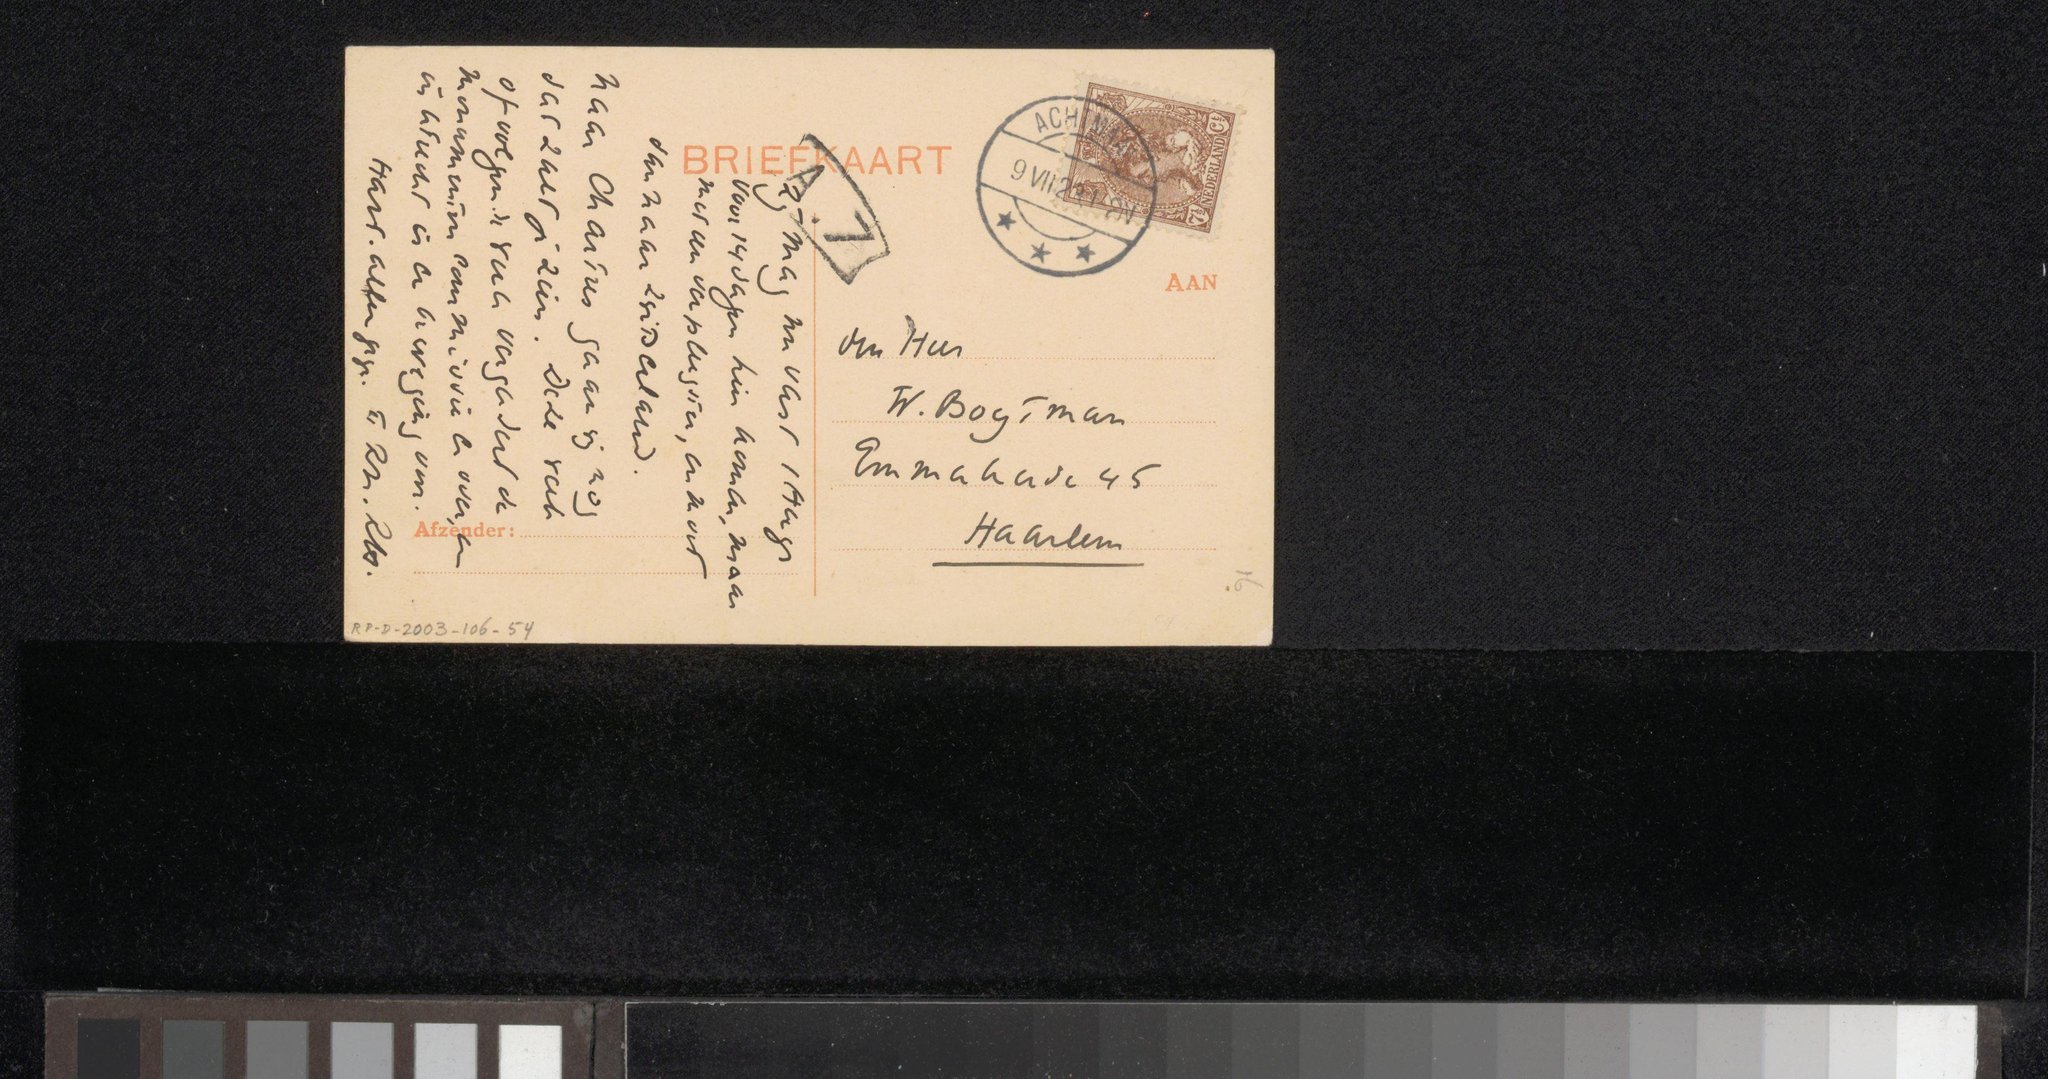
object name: postcard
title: Briefkaart aan Willem Bogtman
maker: richard nicolaüs roland holst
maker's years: 1868-1938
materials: cardboard, ink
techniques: pen, writing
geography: achtmaal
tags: haarlem, willem bogtman, amsterdam, henriëtte roland holst-van der schalk, applied arts, arts and crafts; industrial design, exhibition ~ art, money, utrecht, switzerland